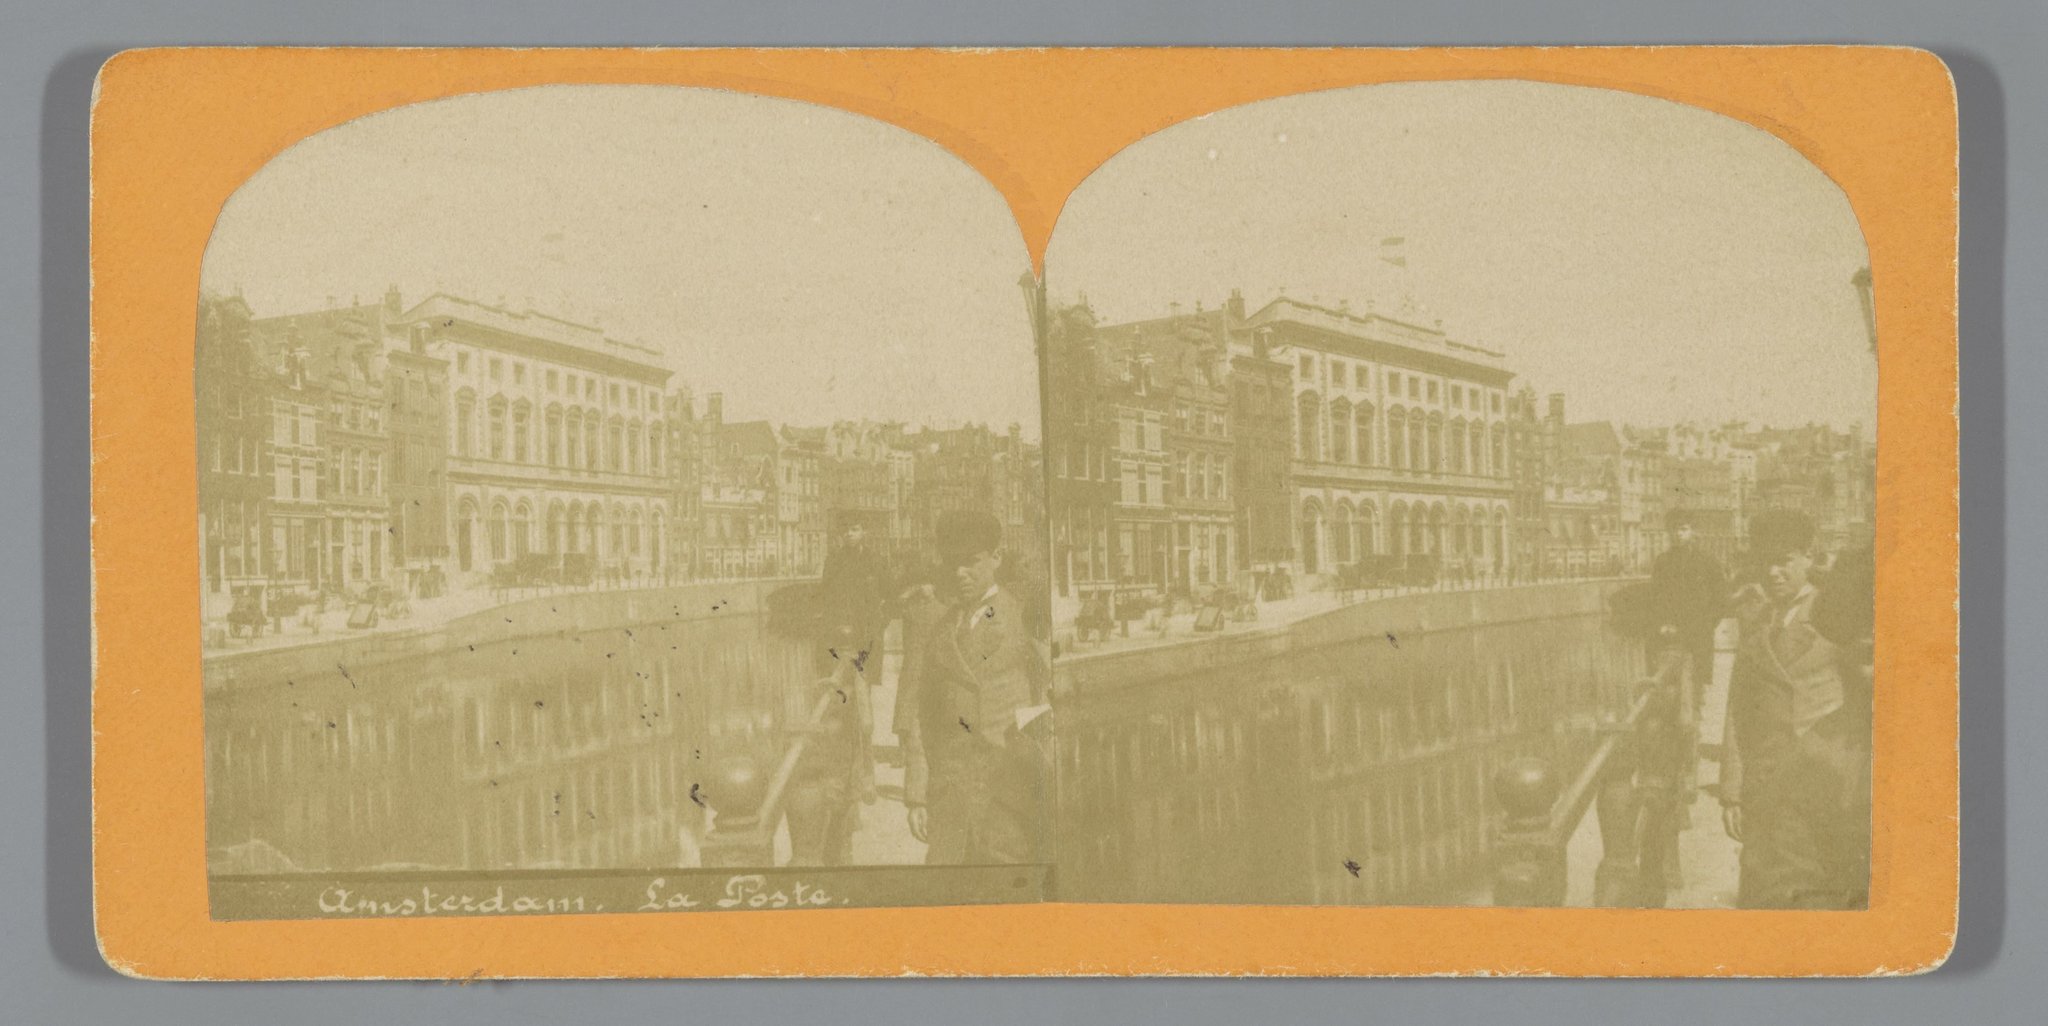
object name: stereograph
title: Nieuwezijds Voorburgwal met het Koninklijk Postkantoor, Amsterdam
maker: Anonymous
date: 1868-1884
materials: cardboard, paper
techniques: albumen print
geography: amsterdam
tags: post-office, canals, waters (in city)